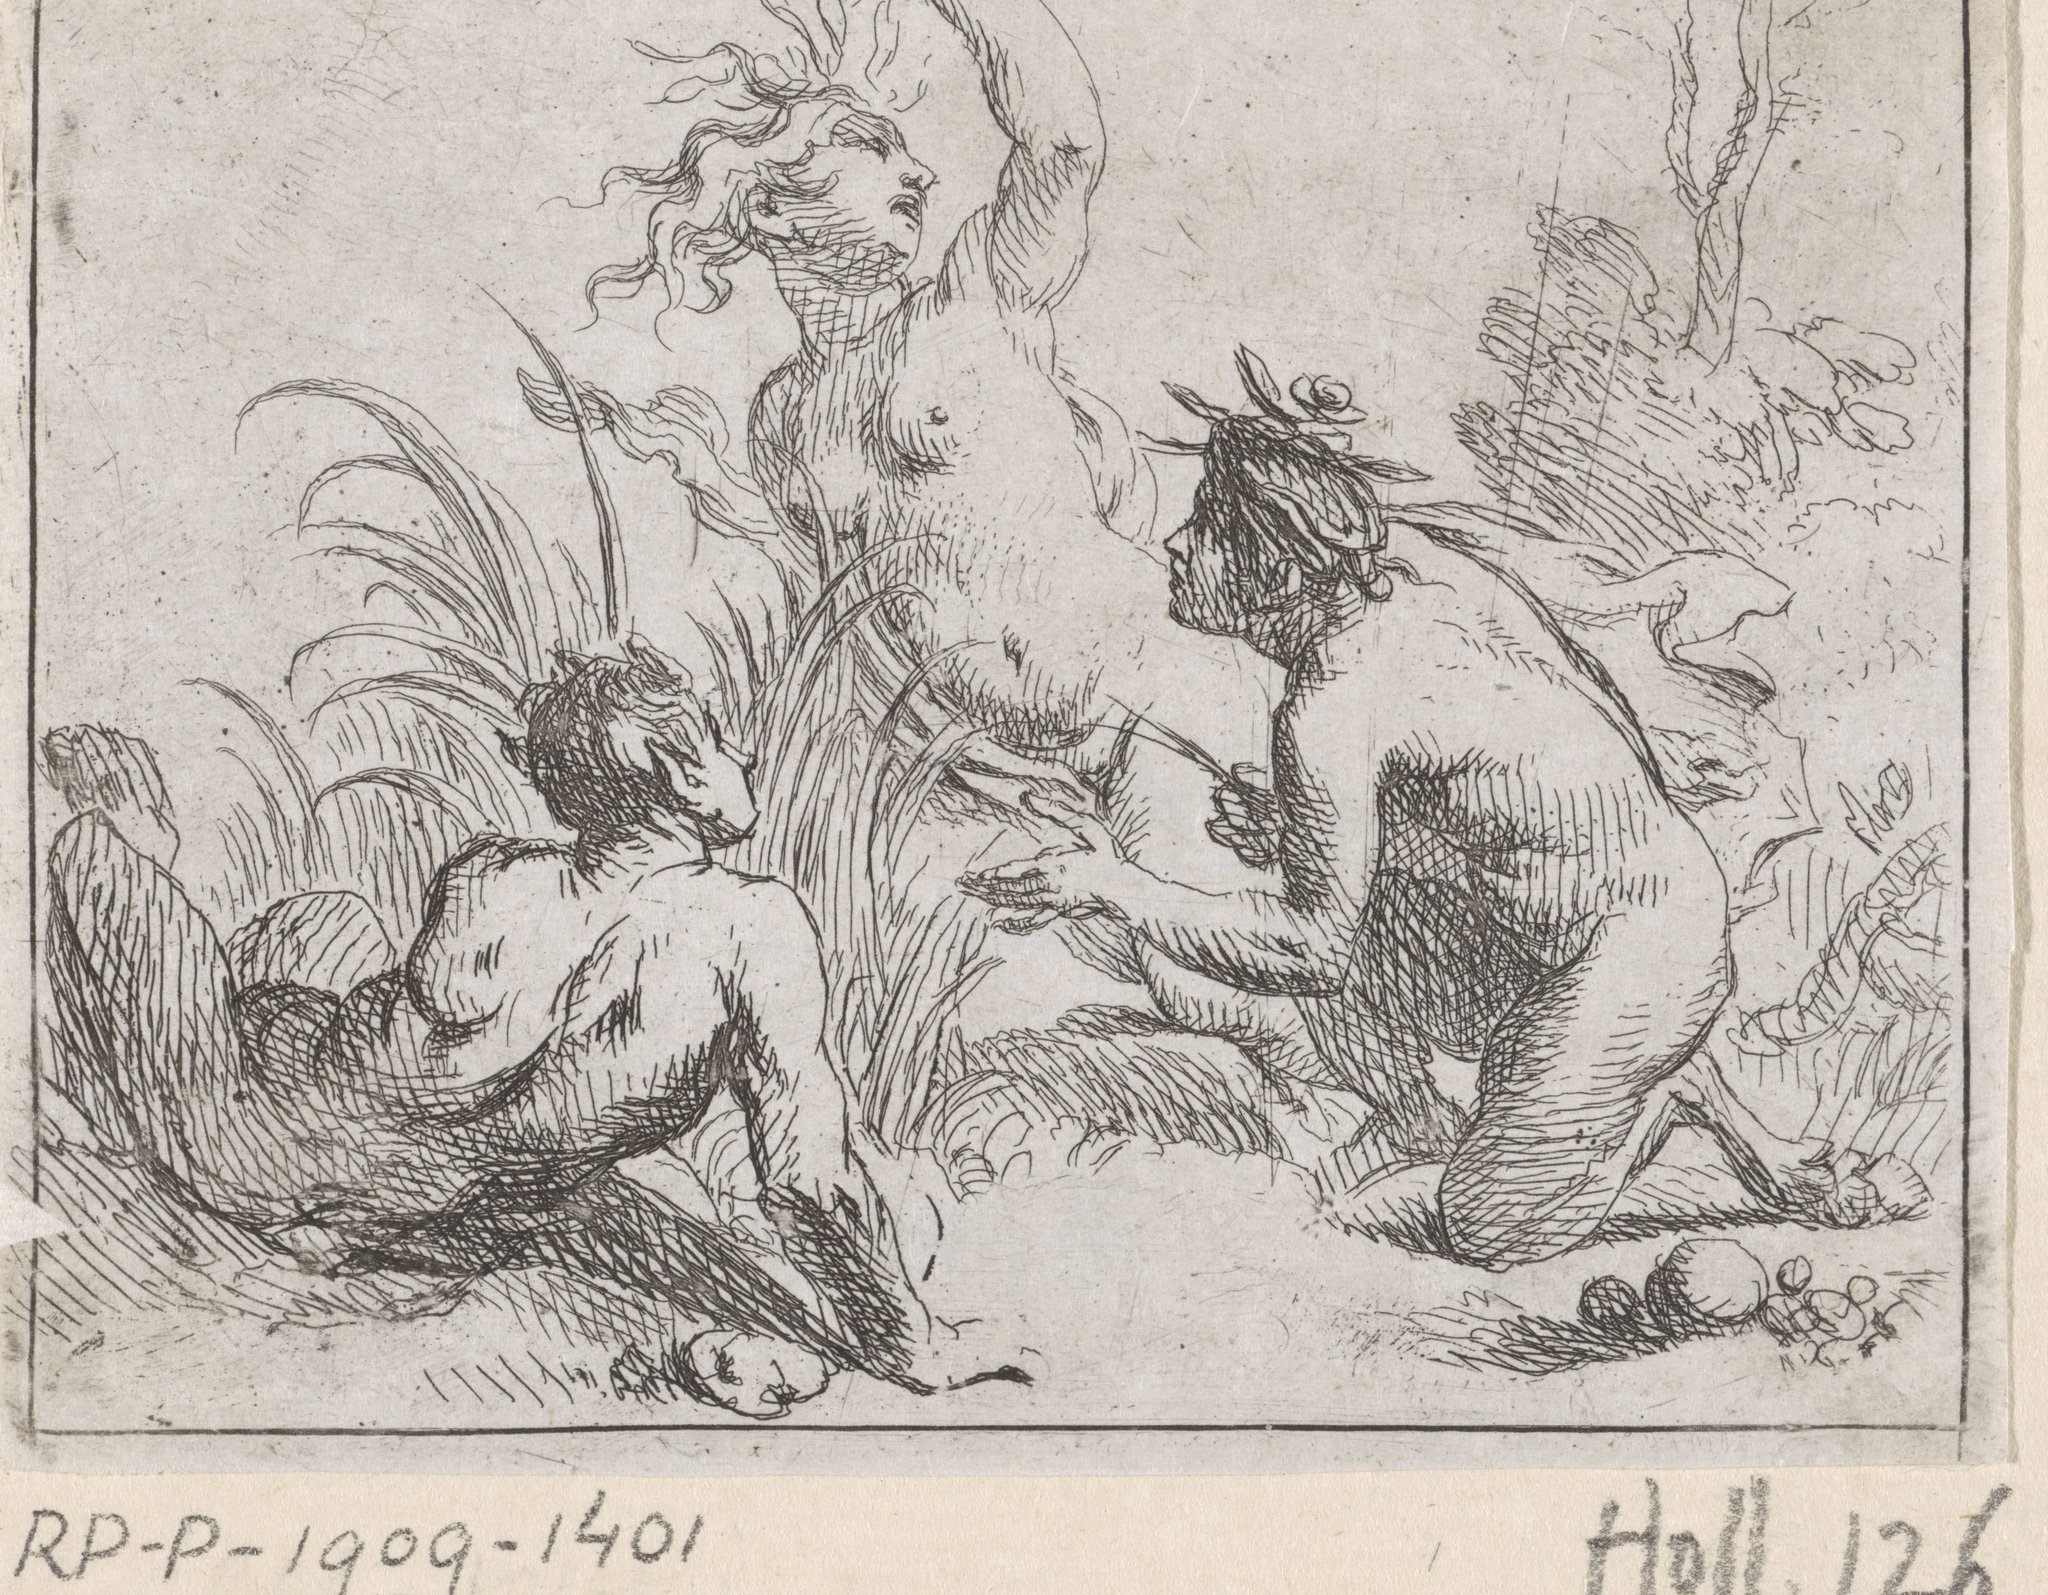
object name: print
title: Nimf met twee saters in een landschap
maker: cornelis schut (i)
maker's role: draughtsman, print maker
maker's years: 1597-1655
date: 1618-1655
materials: paper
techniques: engraving, etching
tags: satyr(s) pursuing nymph(s)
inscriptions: collector's mark: Lugt 2228a